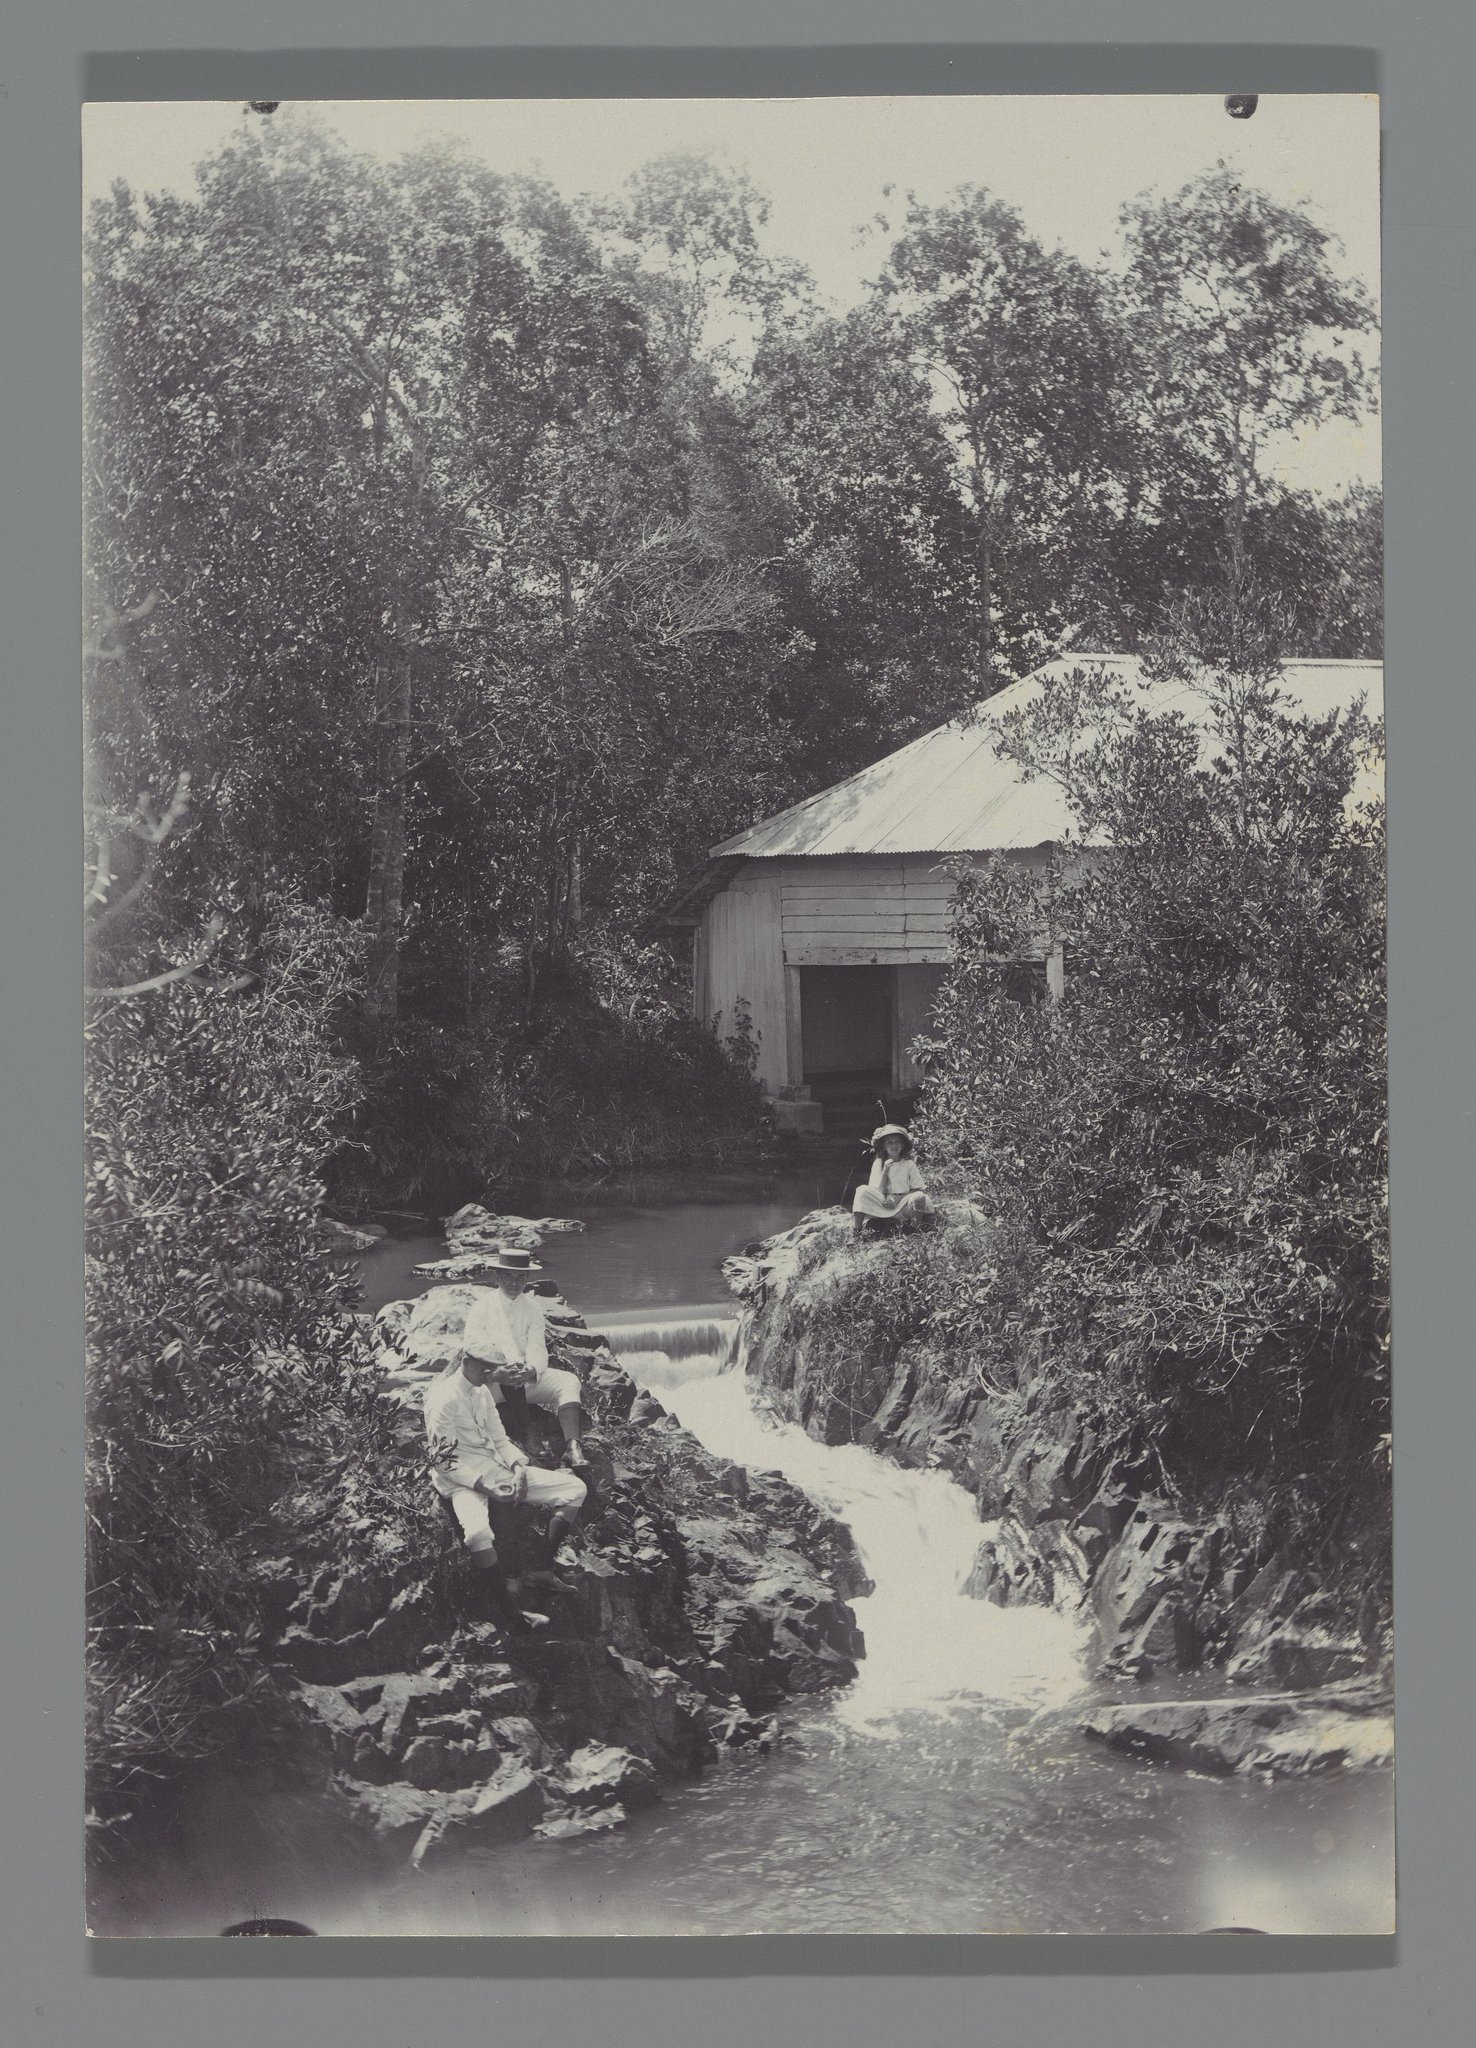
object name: photograph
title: Gezin bij waterval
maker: Anonymous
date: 1914-1919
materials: photographic support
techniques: gelatin silver print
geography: bangka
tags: robert julius boers, waterfall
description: Man, vrouw en dochter zittend poserend bij een waterval. Onderdeel van een groep van losse foto's en tekeningen behorend bij het fotoalbum aangeboden aan Robert Julius Boers bij zijn vertrek naar Nederland in 1919 door het personeel van de Banka-tinwinning.